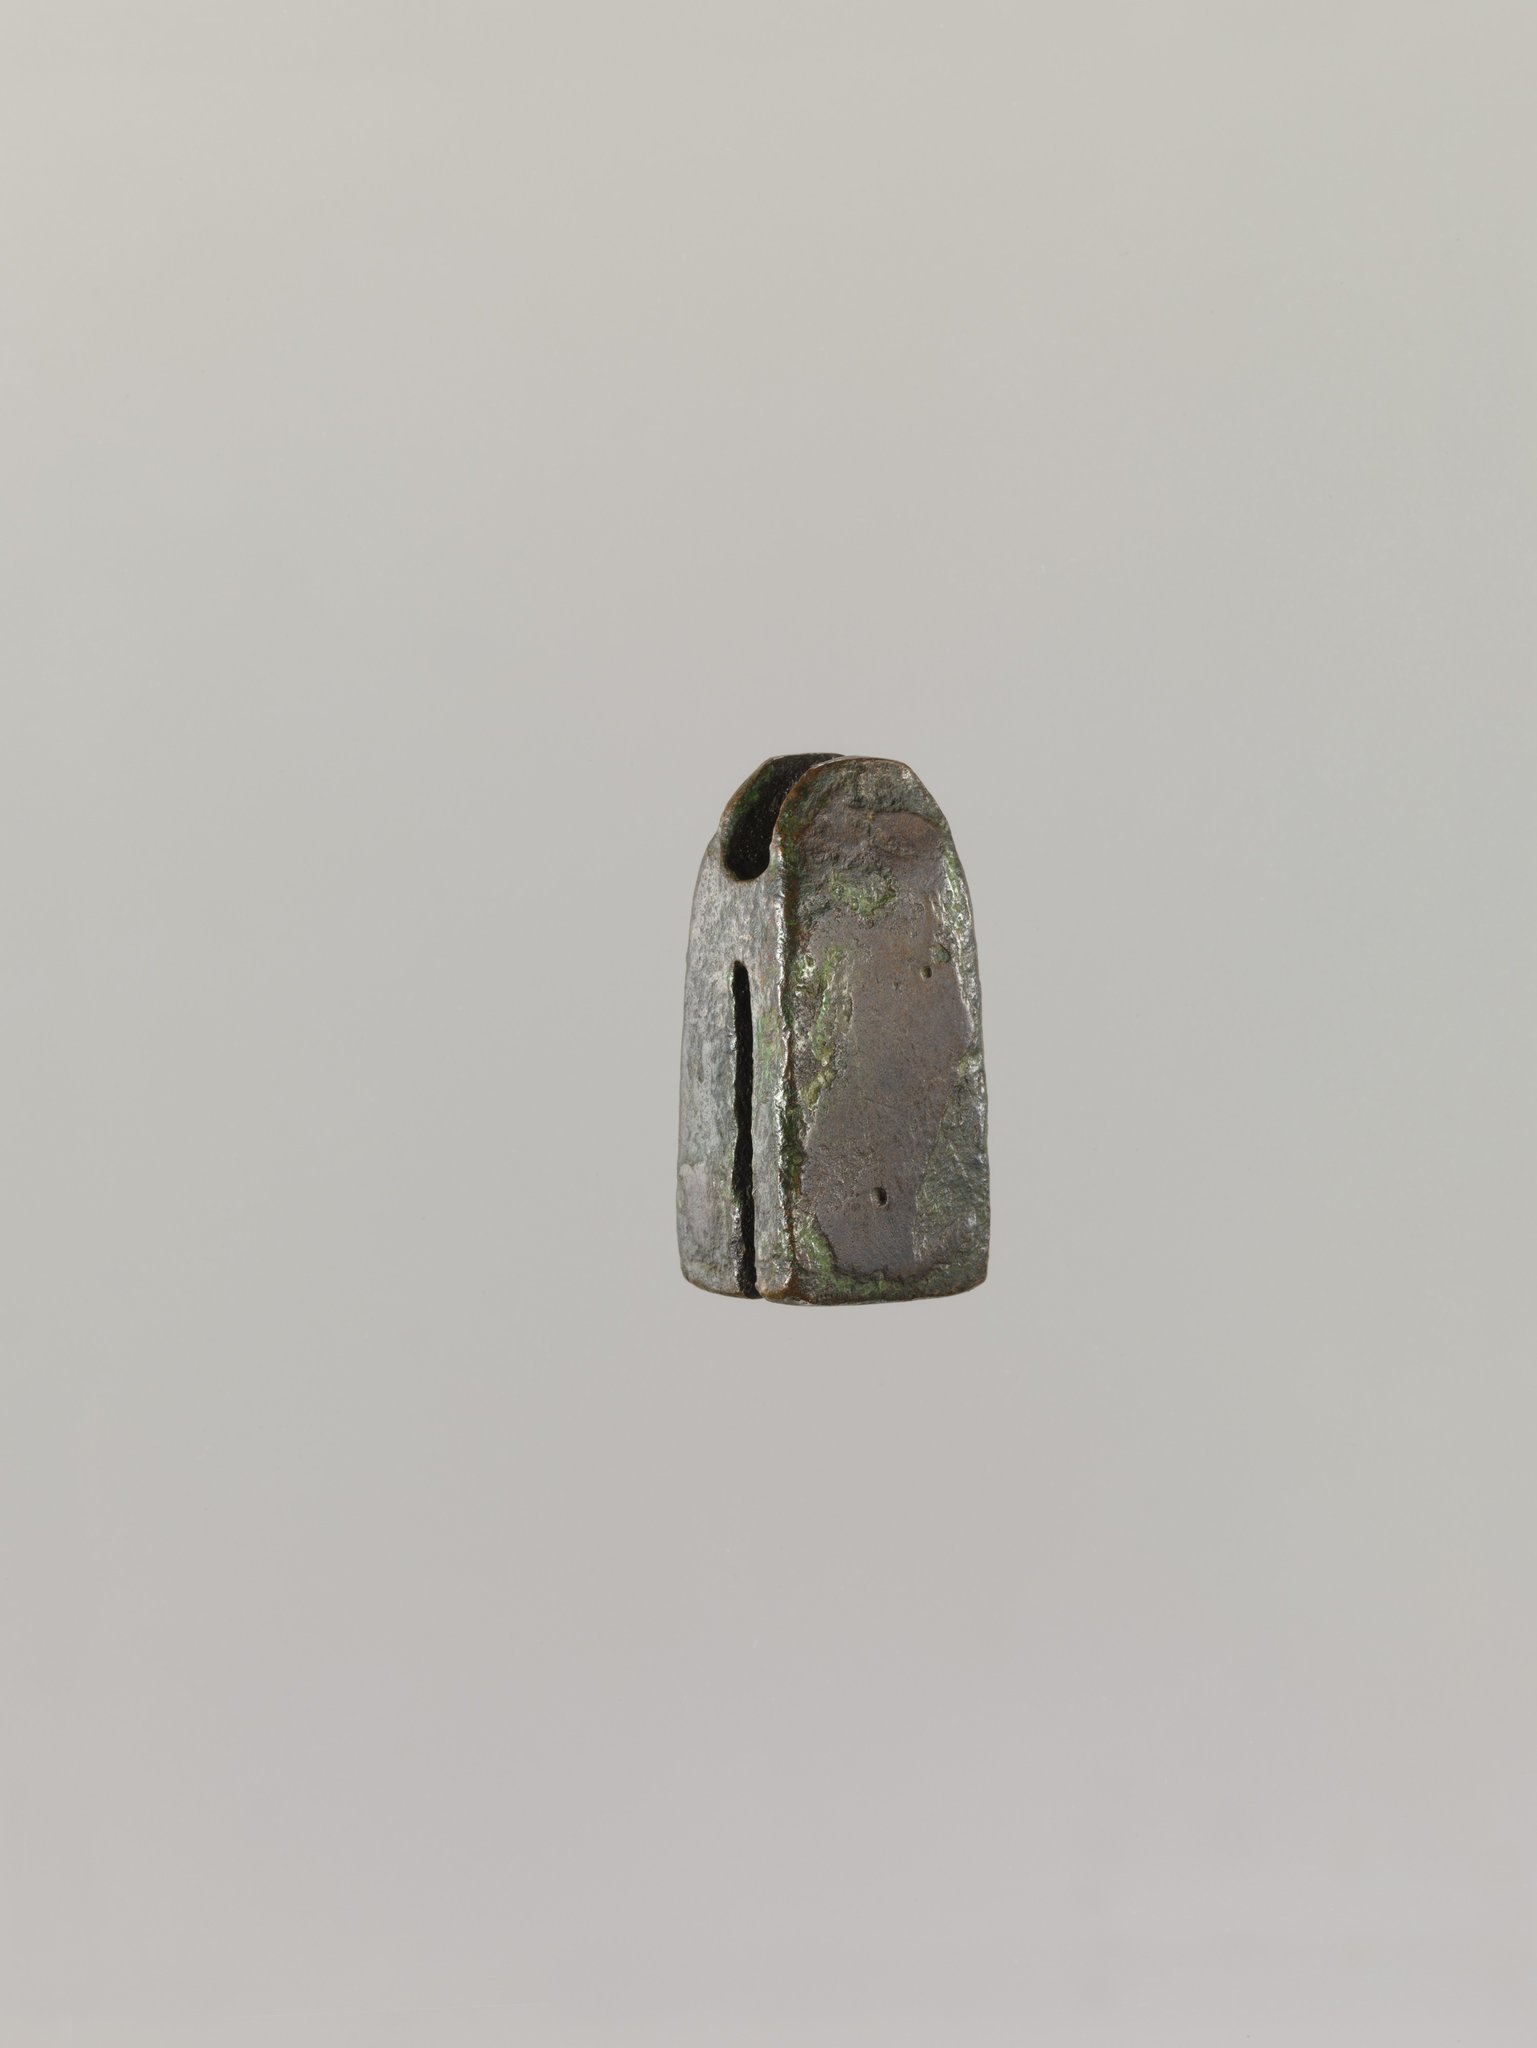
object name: coin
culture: chinese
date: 206 BCE-220 CE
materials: bronze